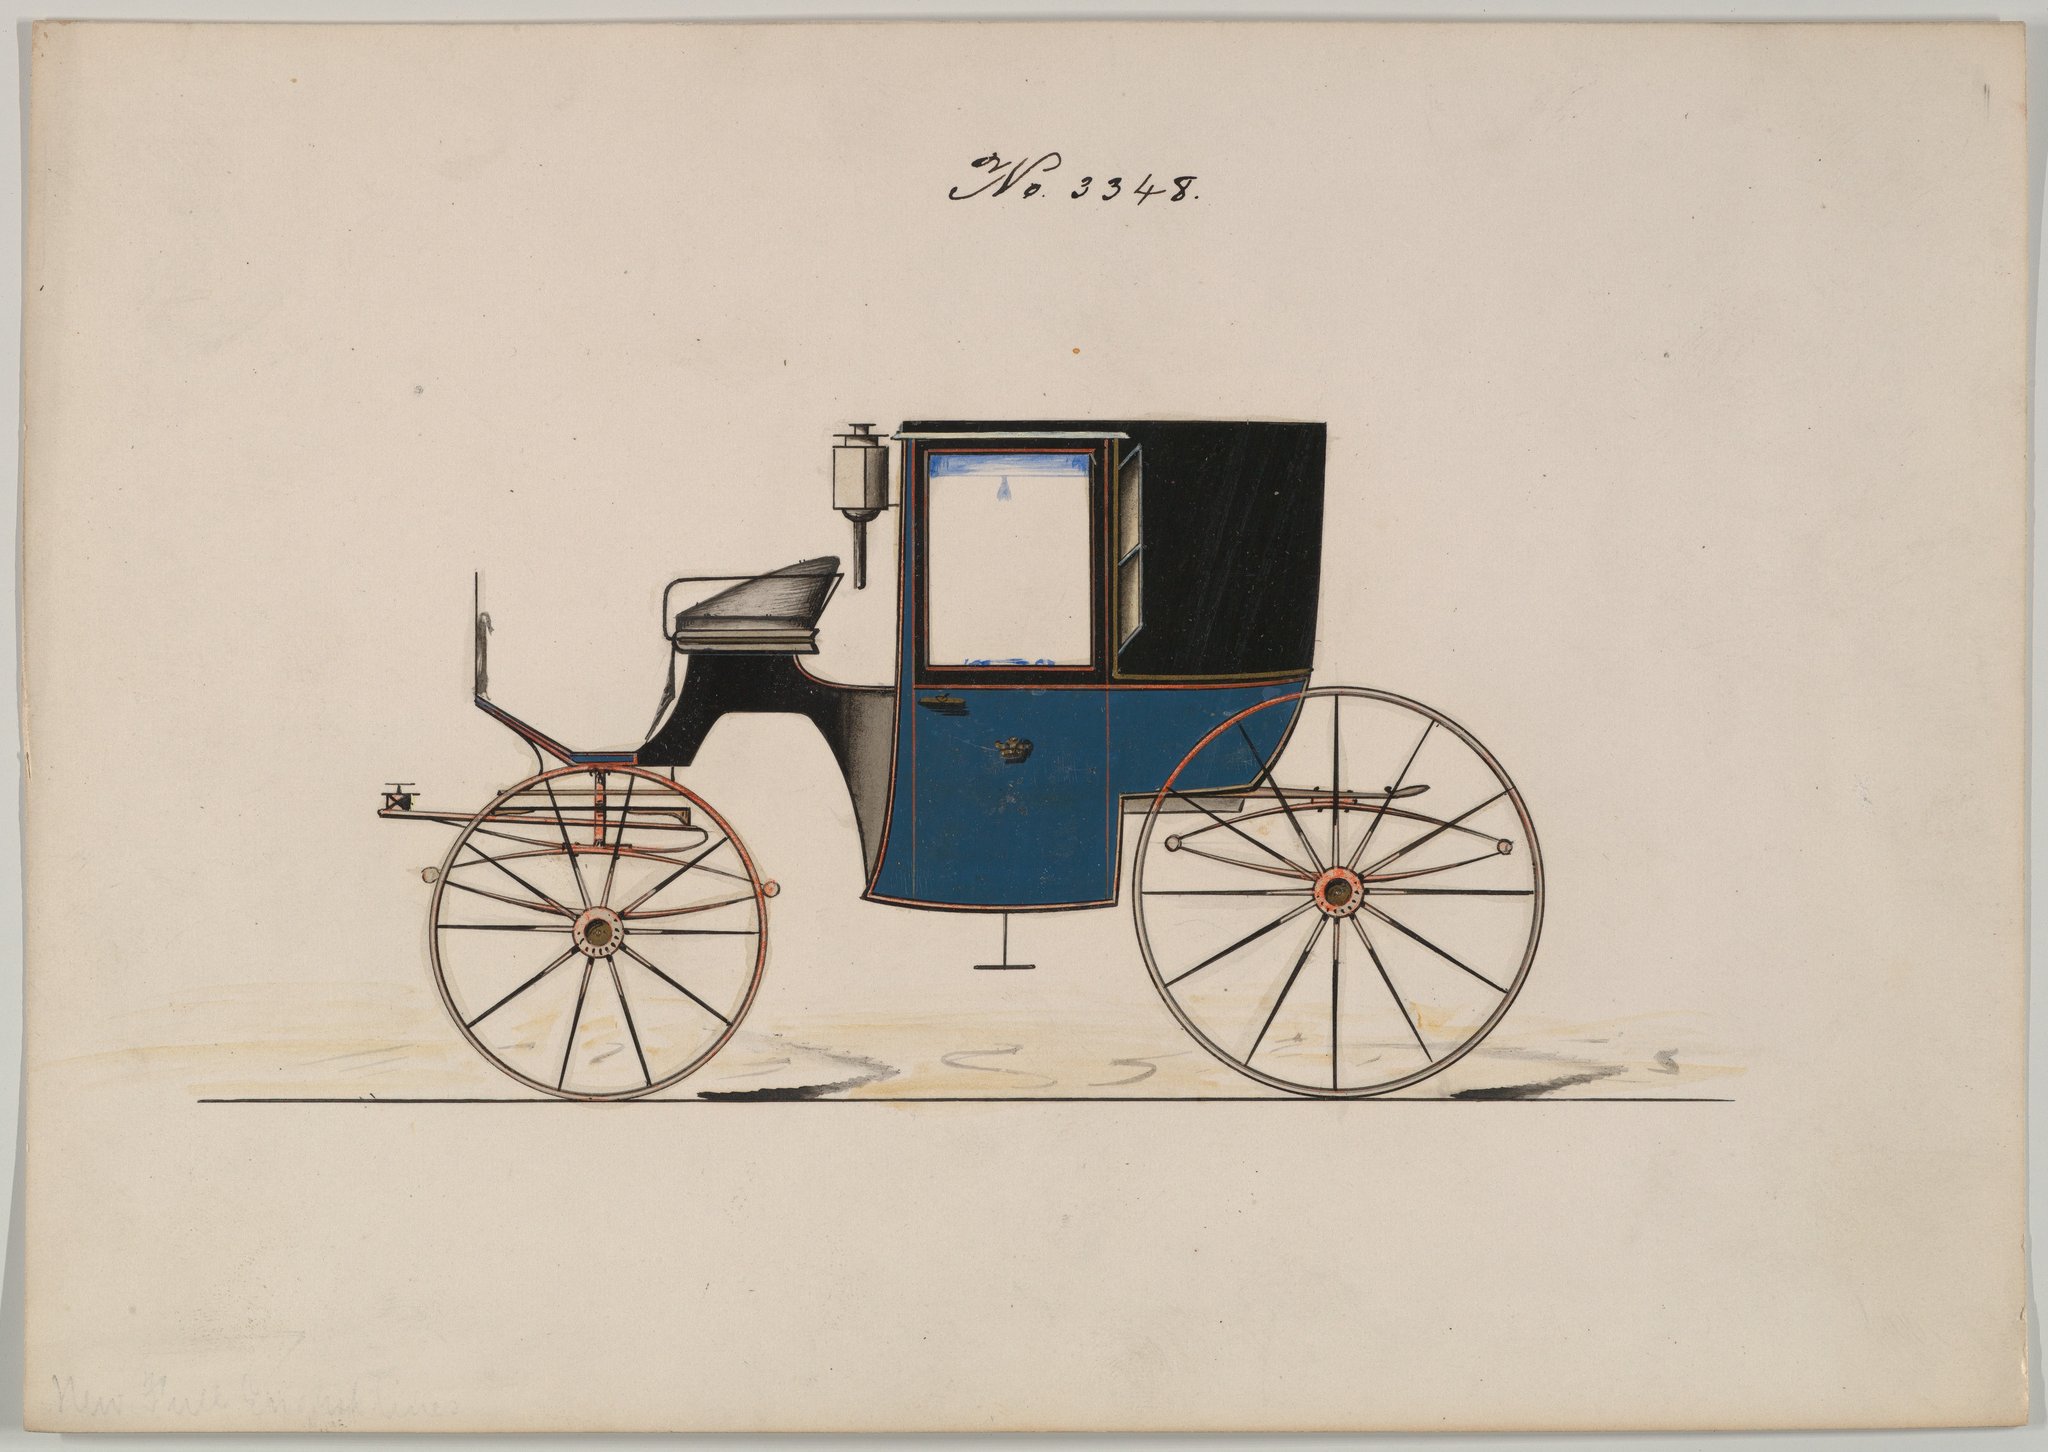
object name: drawing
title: Brougham #3348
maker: brewster & co.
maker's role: manufacturer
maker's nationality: american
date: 1877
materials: gouache, gum arabic, ink, watercolor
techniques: pen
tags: carriages